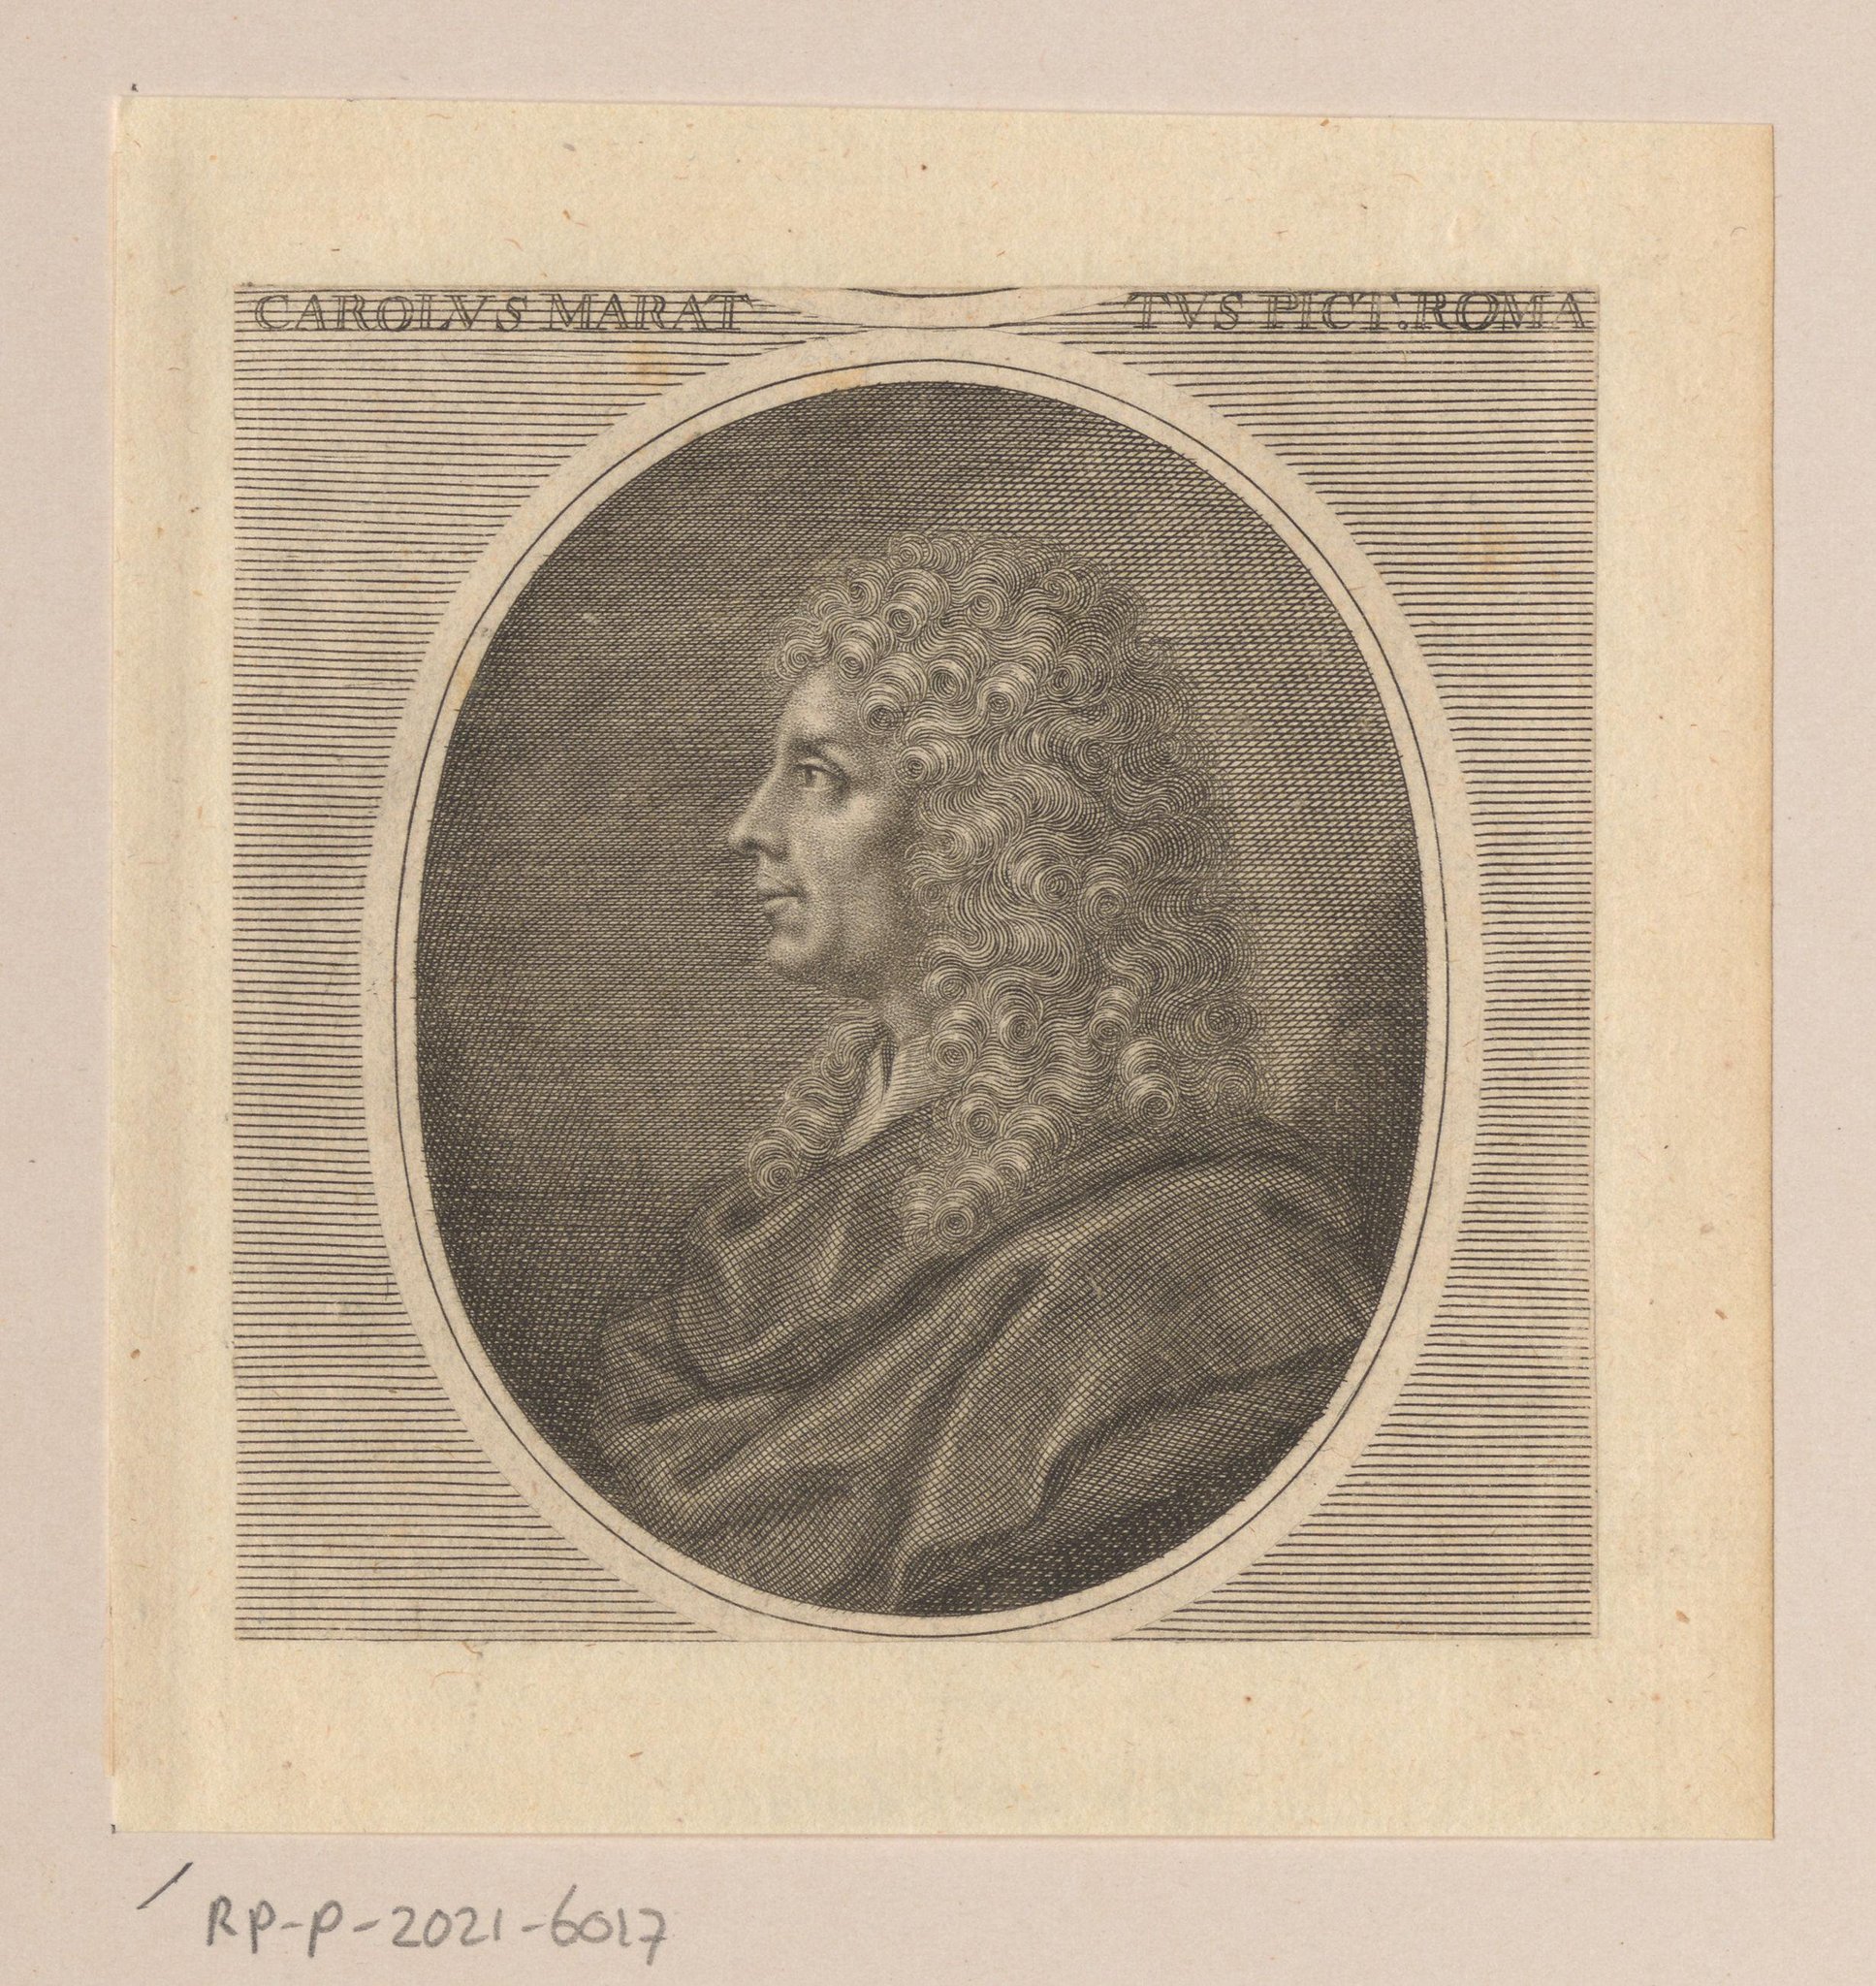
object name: print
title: Portret van Carlo Maratta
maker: Anonymous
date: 1675-1775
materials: paper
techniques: engraving, etching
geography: germany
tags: rome, painter, print maker, draughtsman, carlo maratta, ornament ~ medallion, historical persons, portrait, self-portrait of painter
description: Portret komt mogelijk uit een editie van Joachim von Sandrarts 'Teutsche Academie'. Niet gevonden welke.